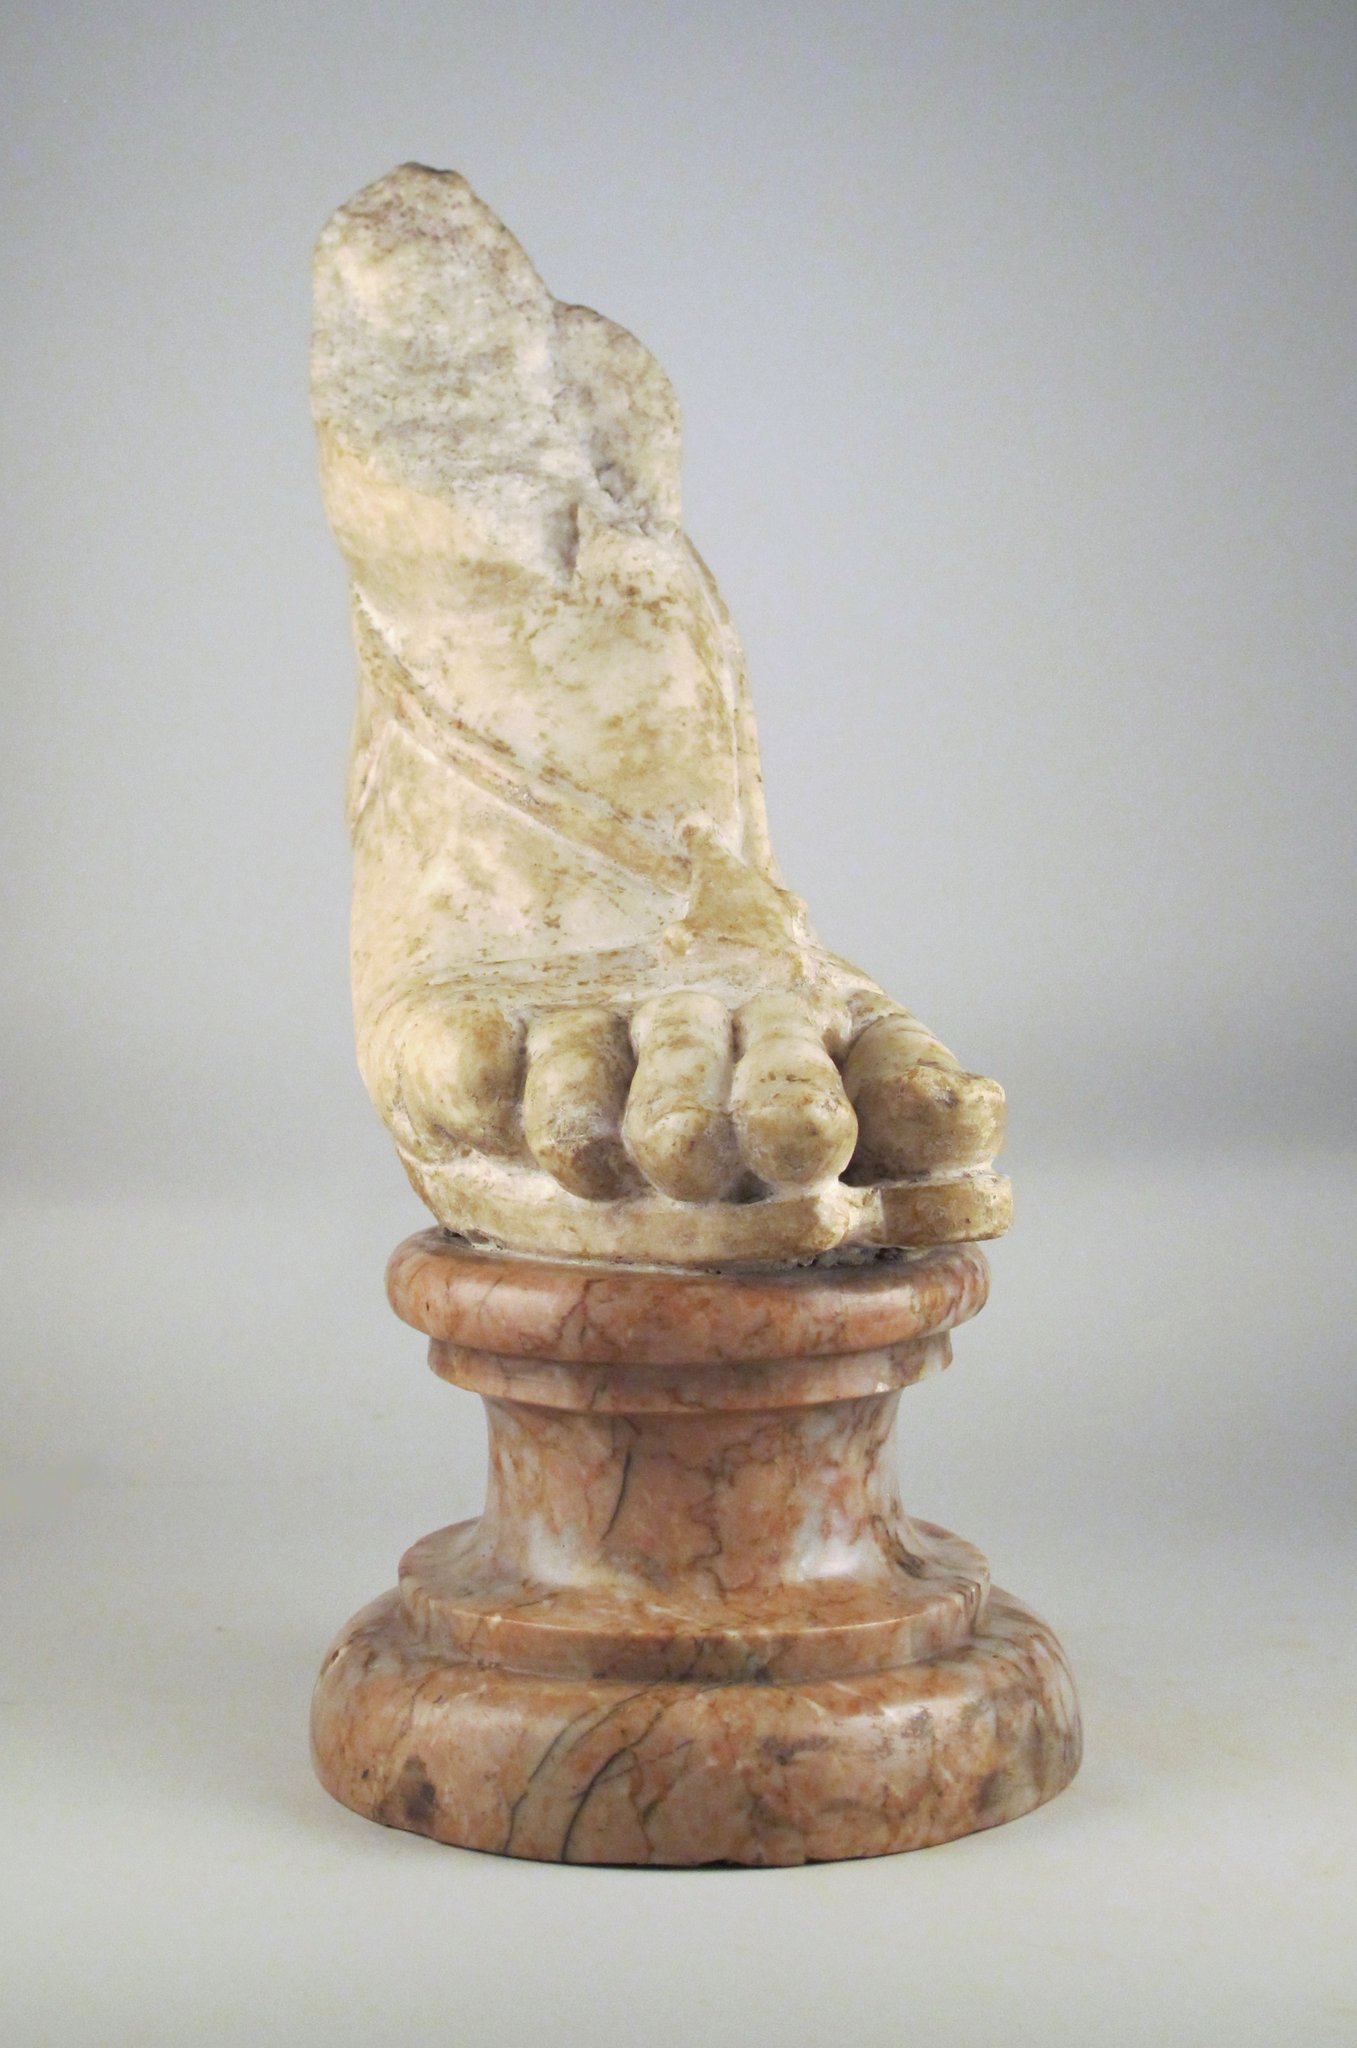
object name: foot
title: Marble foot of a statue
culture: roman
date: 31-330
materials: marble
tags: feet